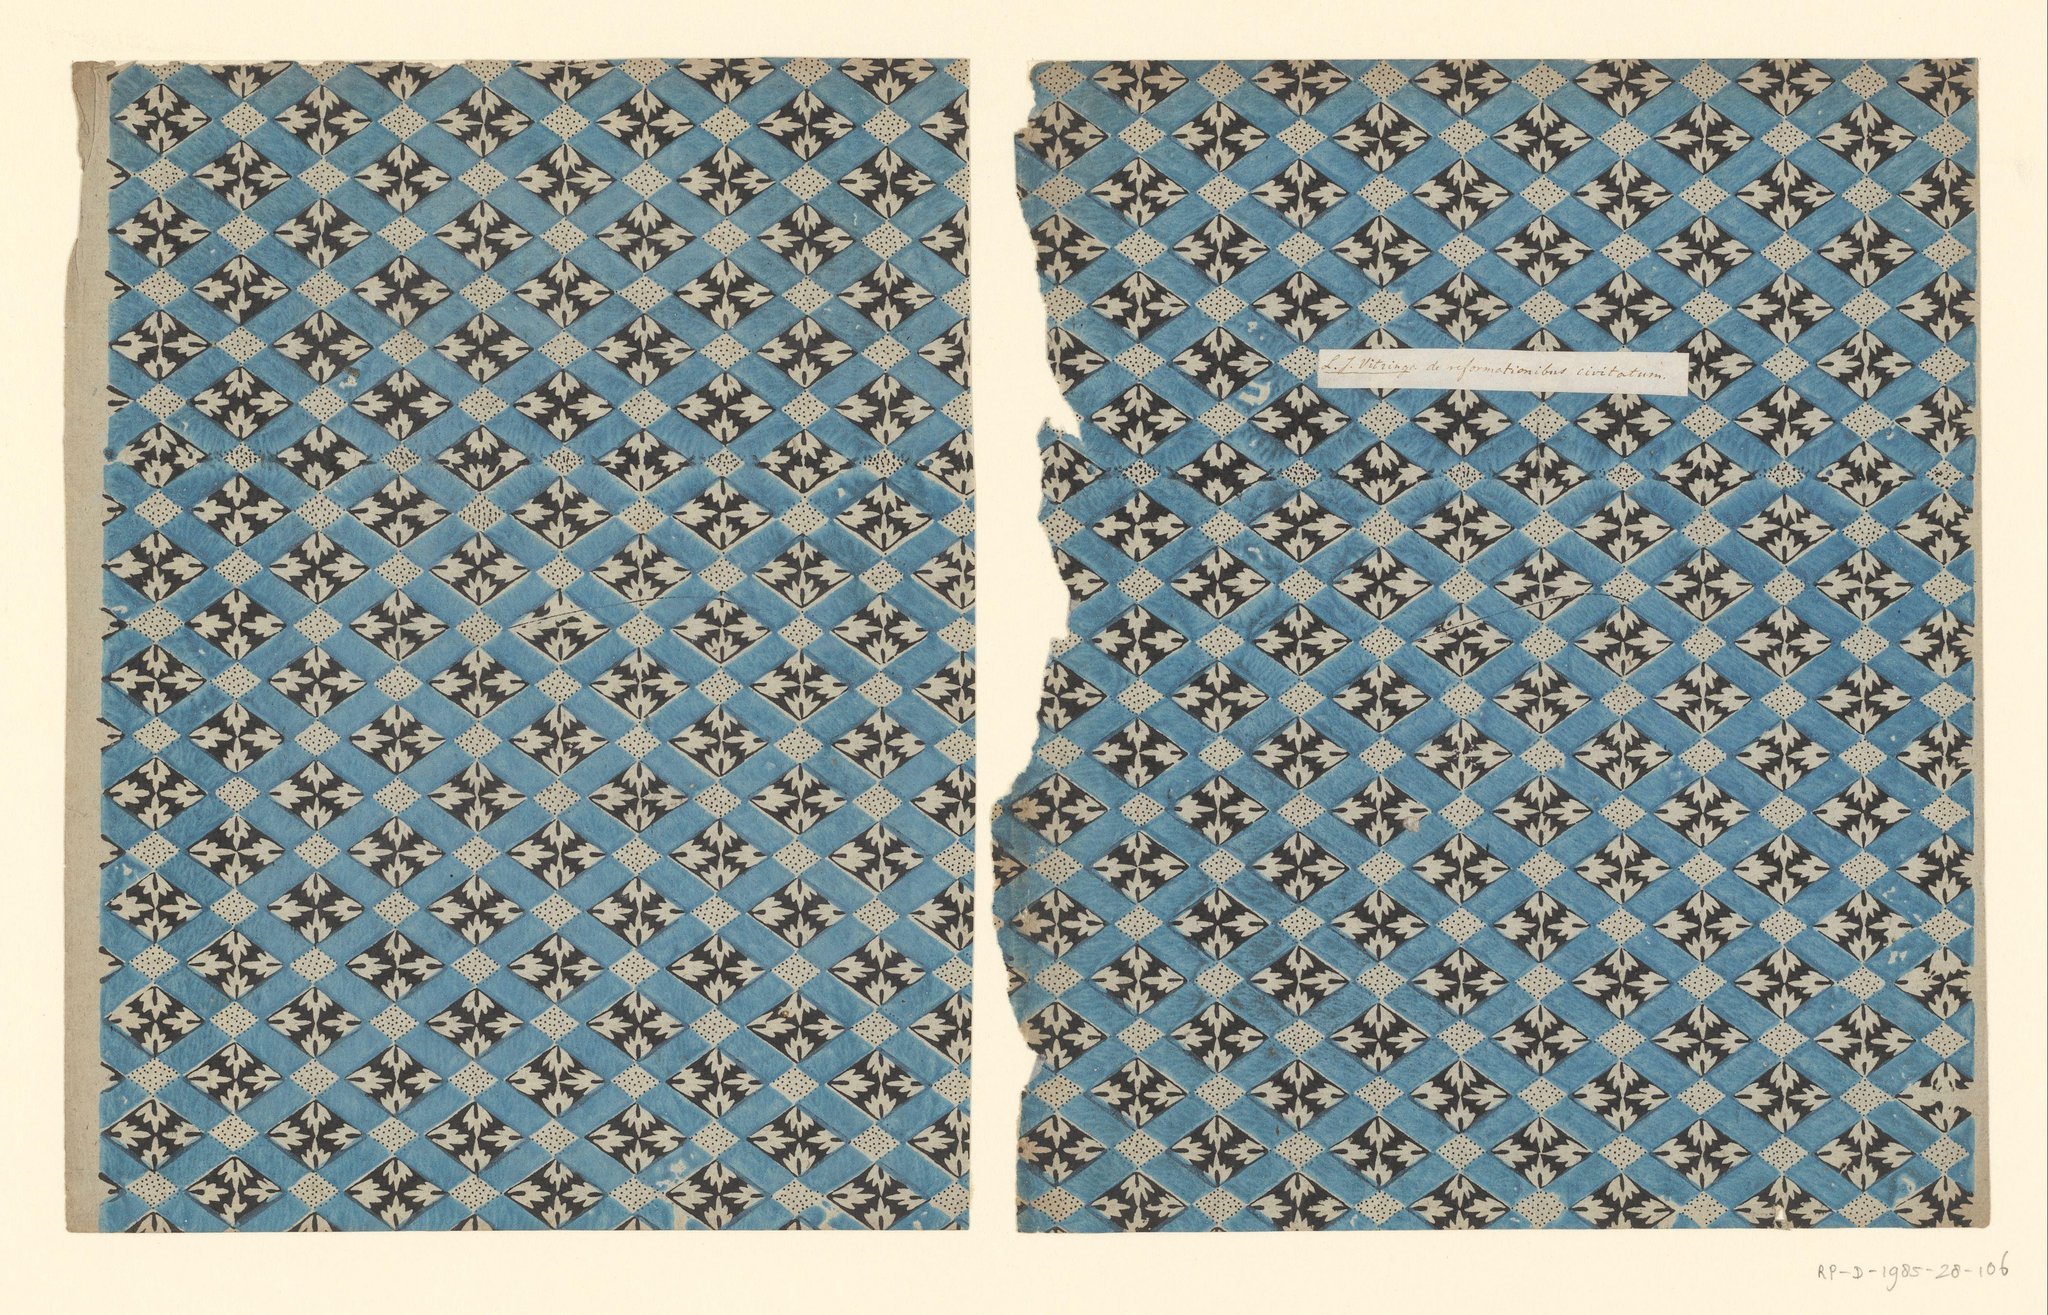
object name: printed paper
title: Twee bladen met ruitenpatroon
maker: Anonymous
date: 1750-1900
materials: paper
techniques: printing block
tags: fantasy ornament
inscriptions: collector's mark: Lugt 2760, collector's mark: Lugt 2228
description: Twee bladen met ruitenpatroon. Met etiket met opschrift: 'L.J. Vitringa ... civitatum'. Omslag bestaande uit twee lossen delen.